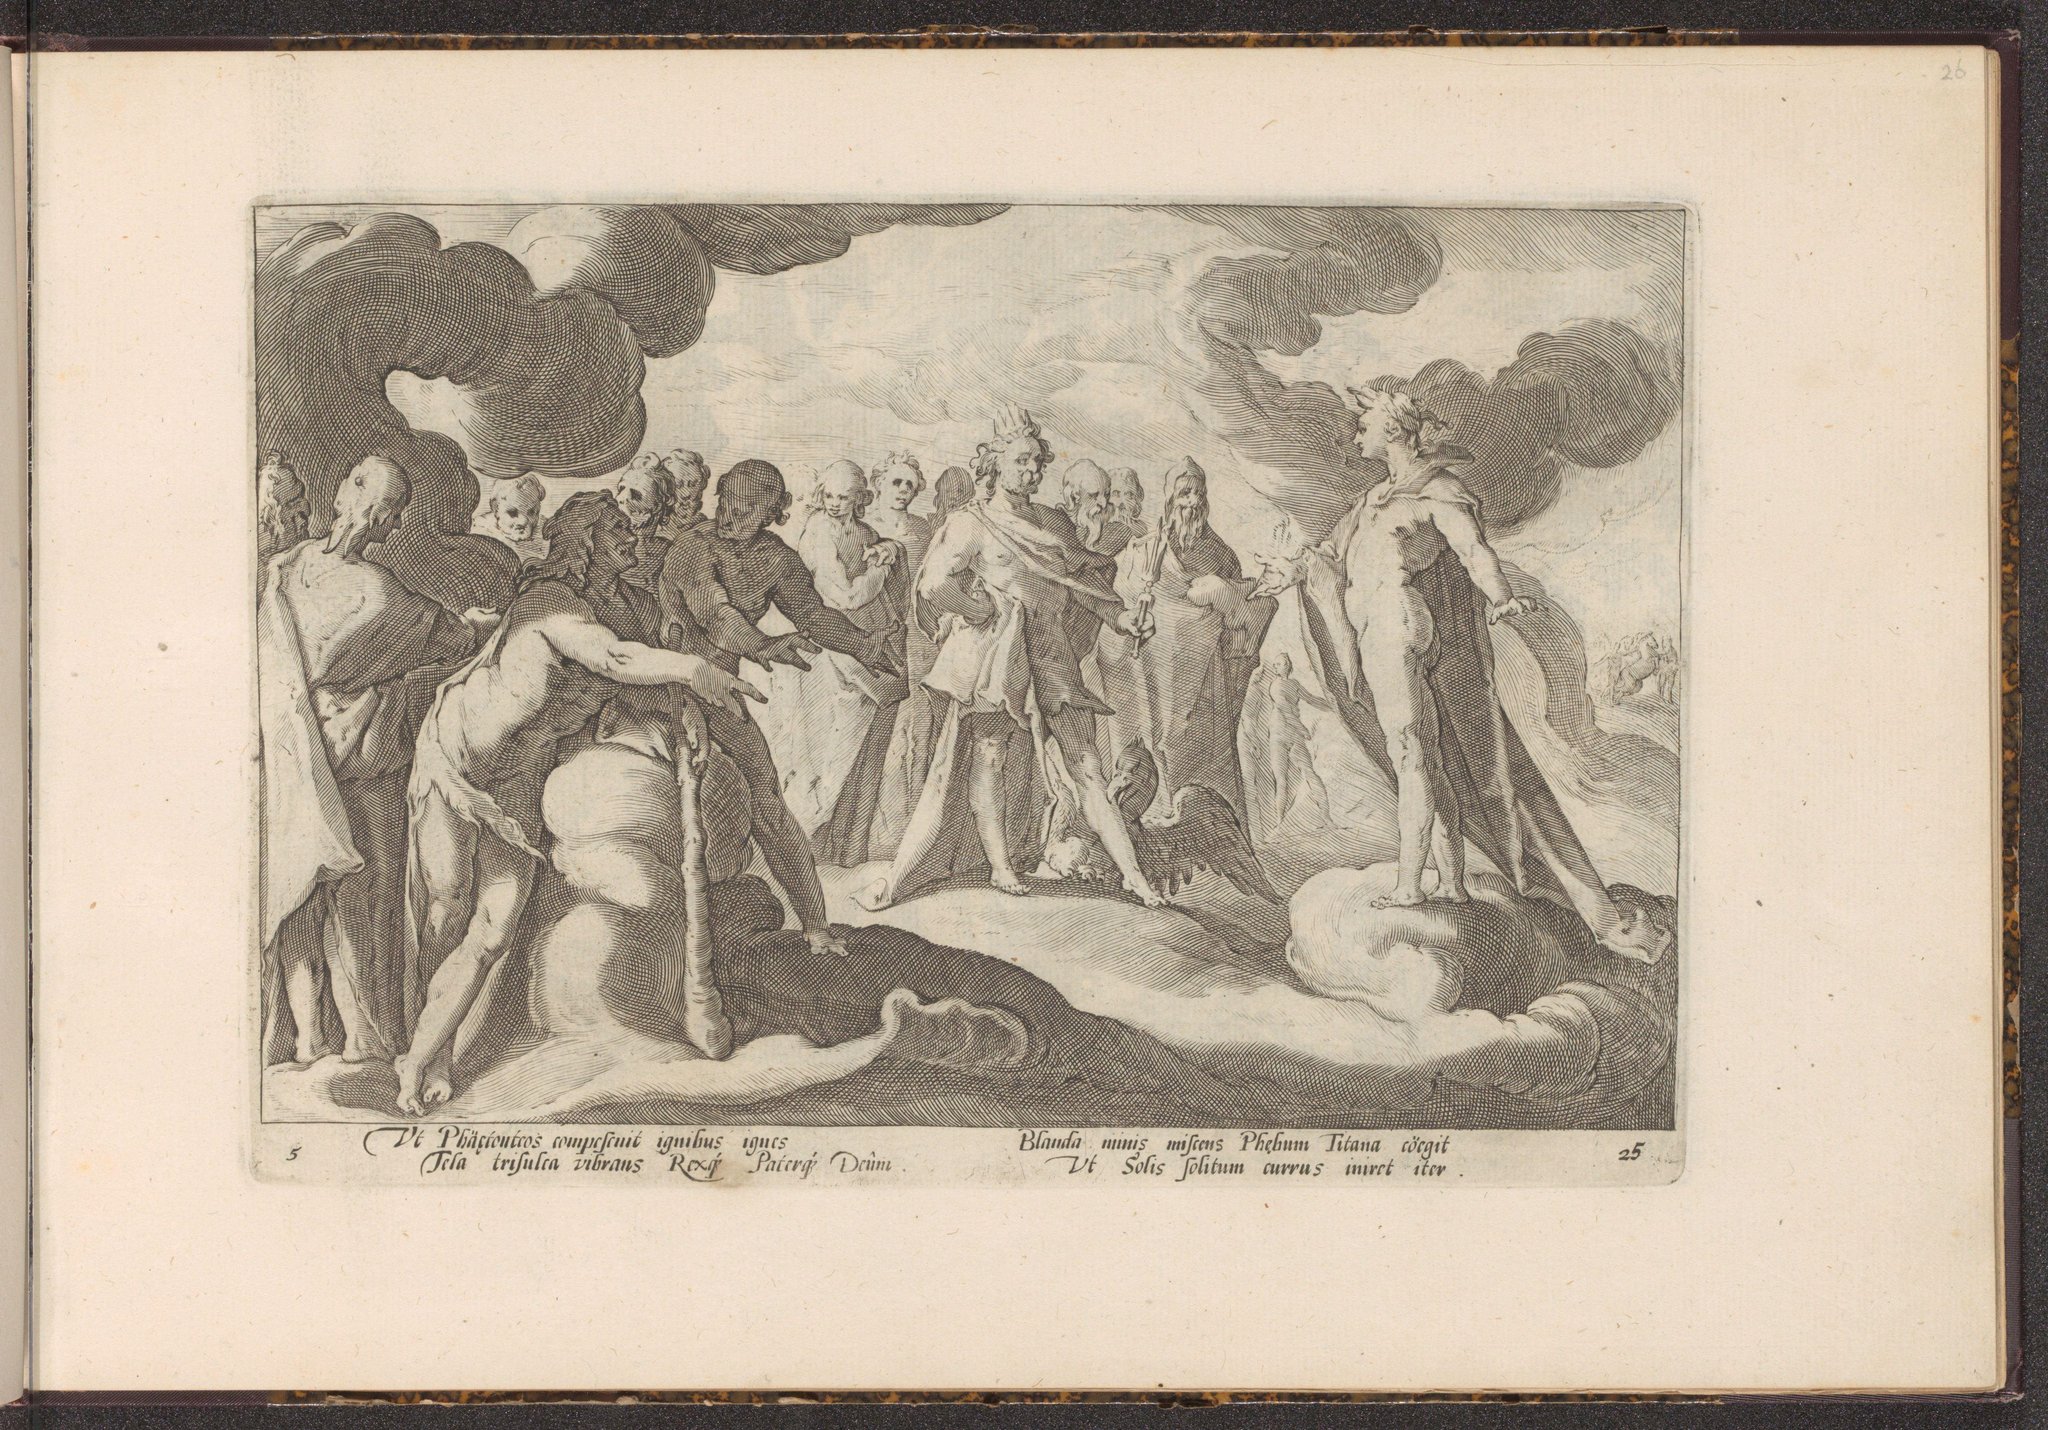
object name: print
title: Goden verzoeken de zonnegod om weer in zijn wagen te rijden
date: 1590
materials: paper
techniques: engraving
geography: haarlem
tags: the gods beg apollo (sol), mourning for the death of phaethon, to drive his chariot again, attributes of hercules, (story of) jupiter (zeus)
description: Na de dood van Phaëthon hult de zonnegod zich in rouw en weigert nog in de zonnewagen te rijden. De goden, onder wie Jupiter, verzoeken hem om weer in zijn kar langs de hemel te gaan rijden. Links staat Hercules met knots een leeuwenmantel. Onder de voorstelling twee keer twee versregels in het Latijn. De prent maakt deel uit van een album.